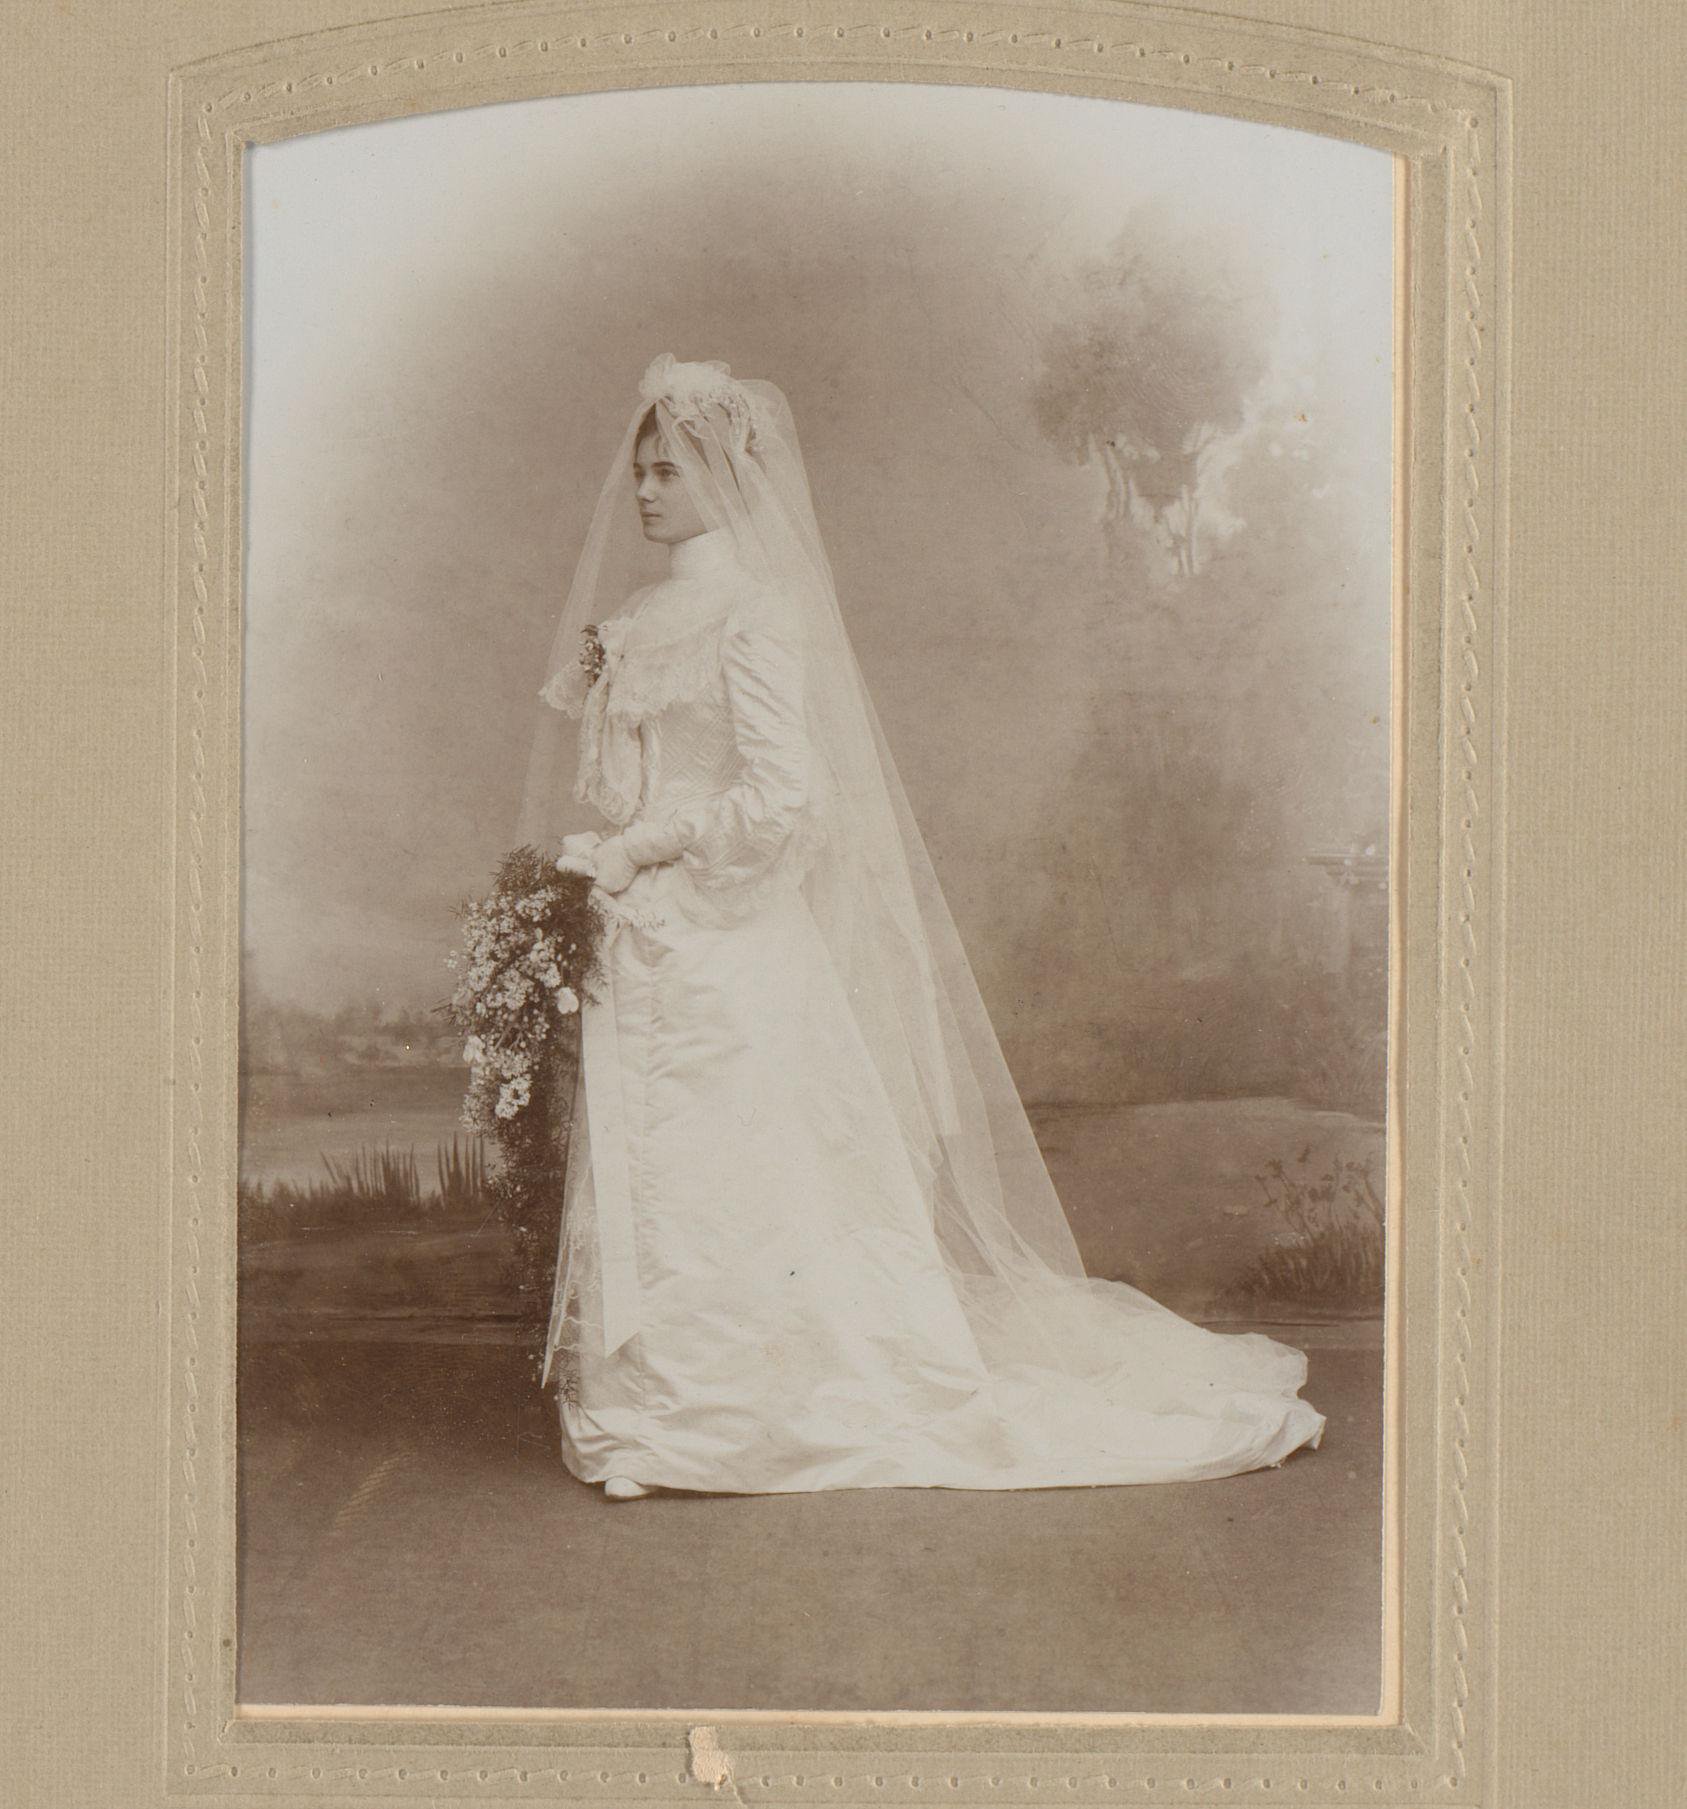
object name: photograph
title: Studioportret van een bruid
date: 1900-1910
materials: paper, photographic support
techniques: gelatin silver print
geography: netherlands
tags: veil